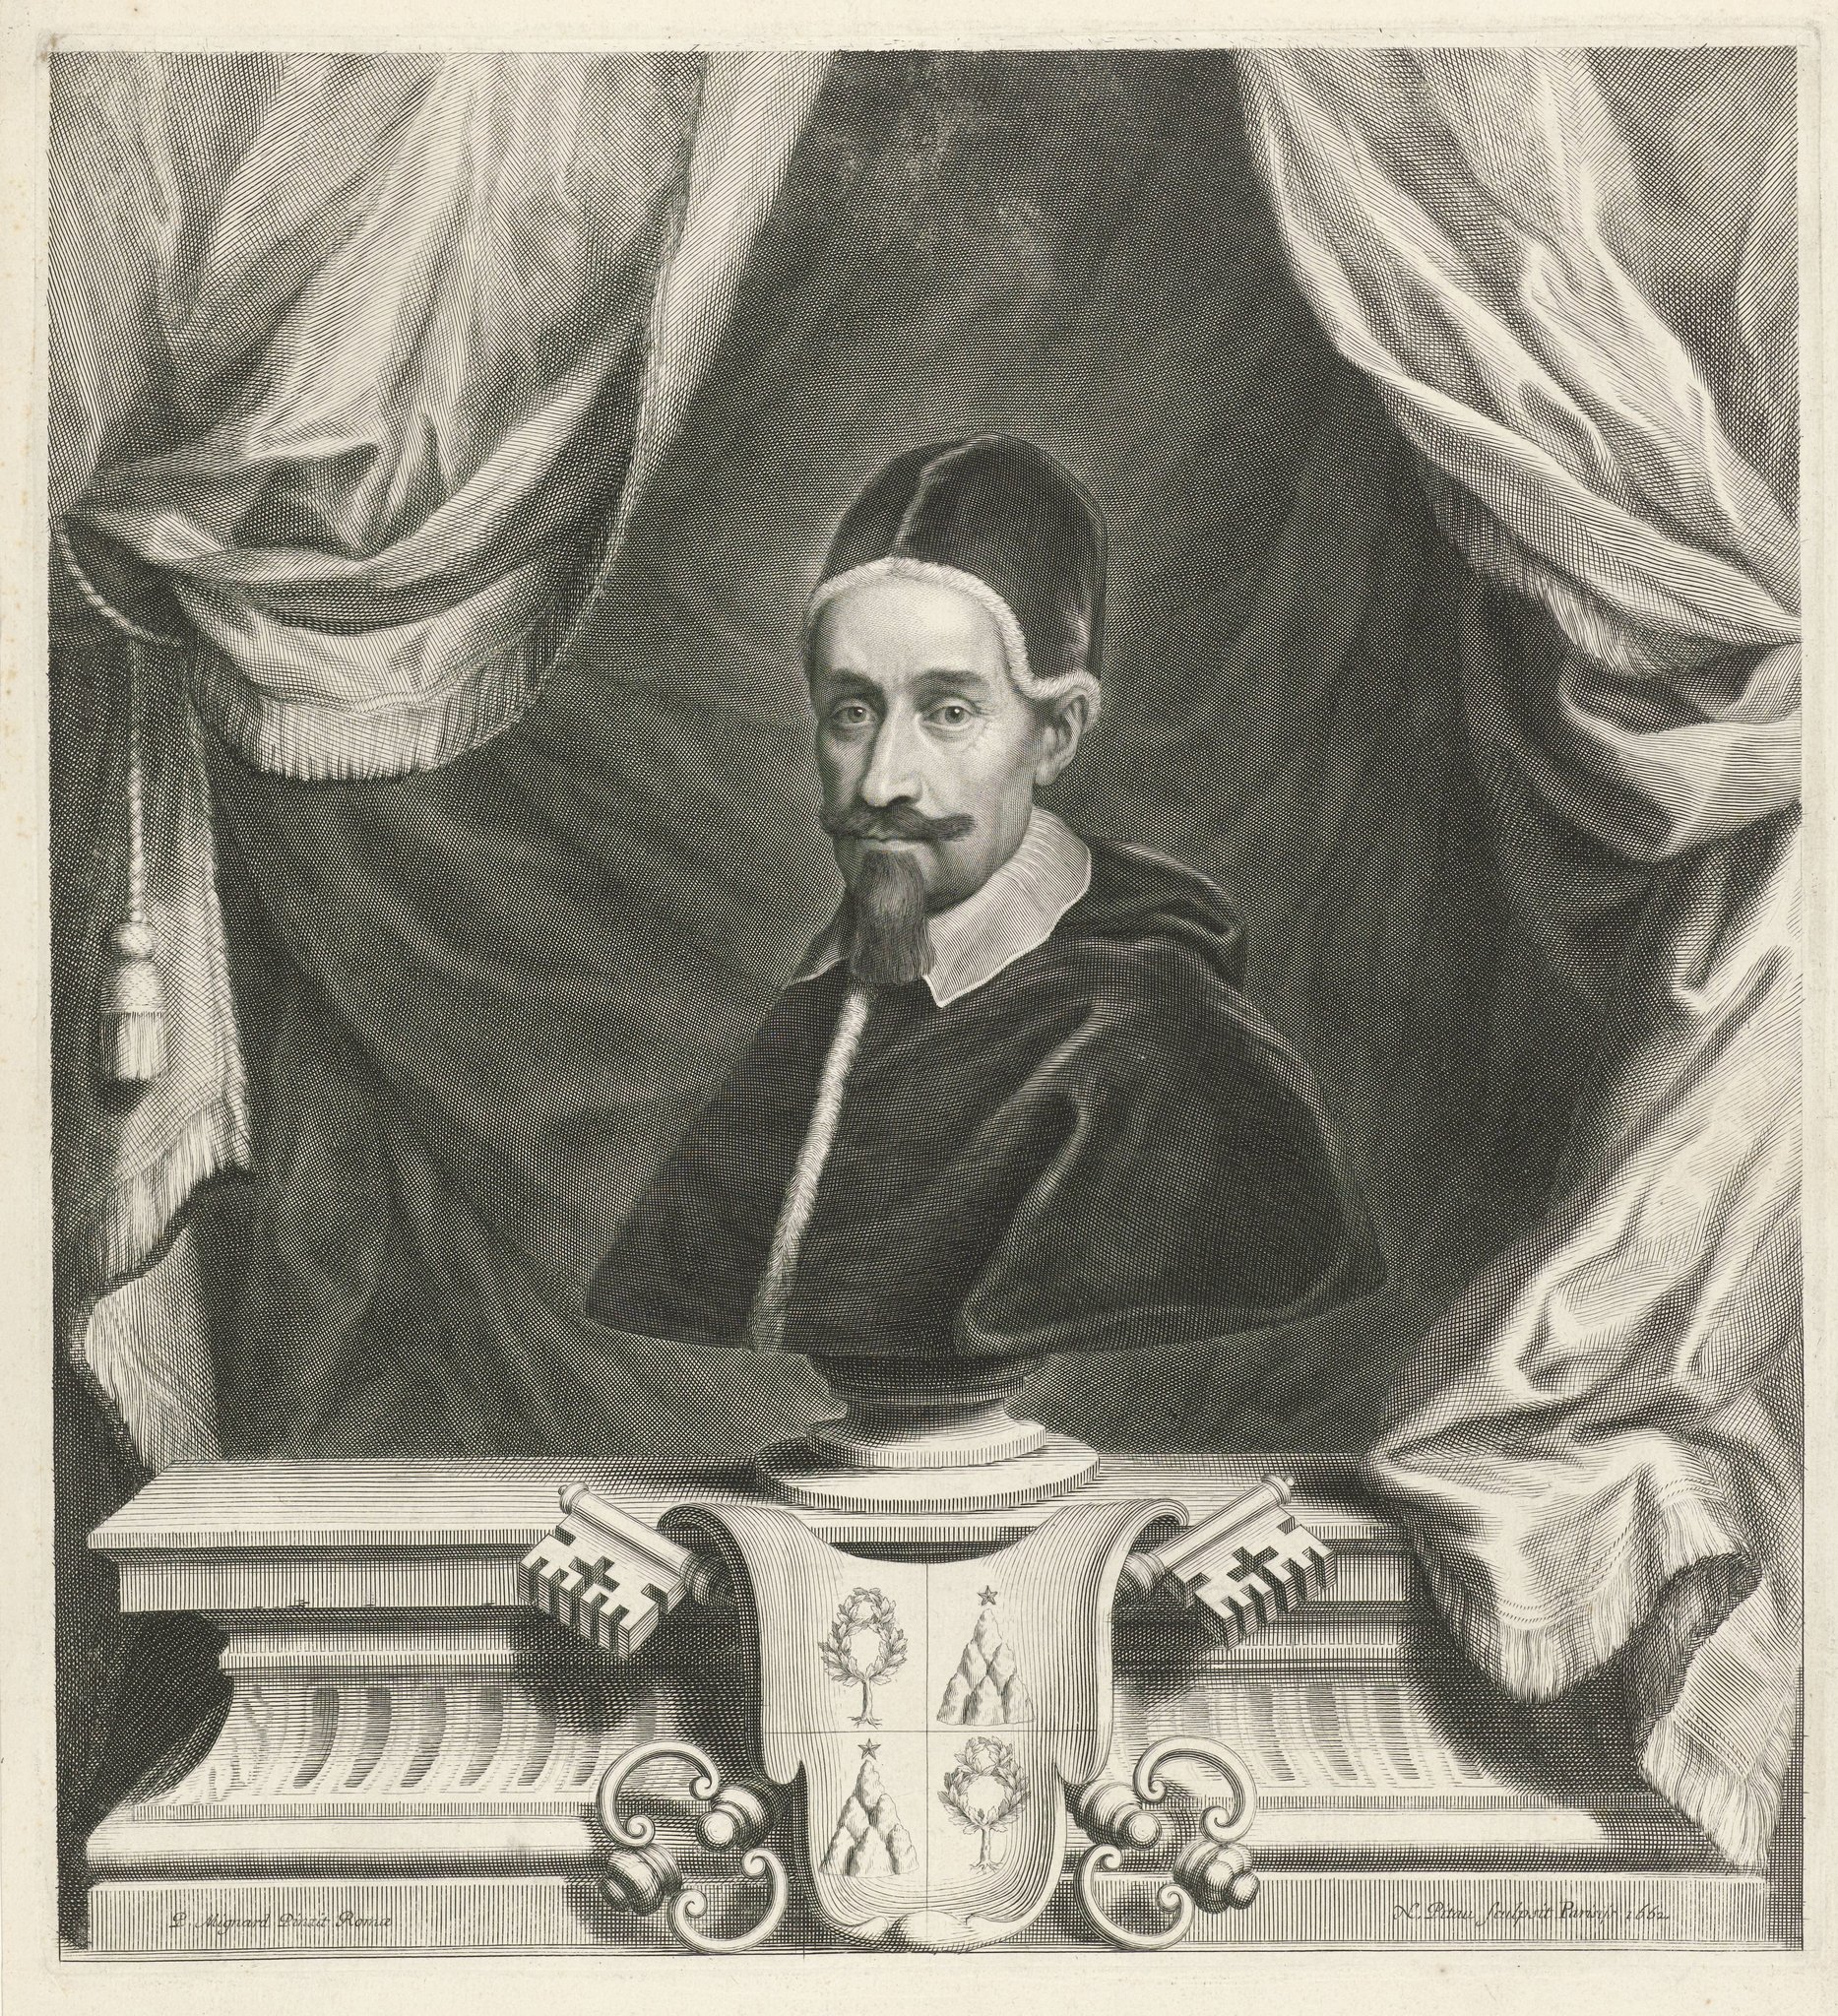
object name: print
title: Busteportret van paus Alexander VII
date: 1662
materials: paper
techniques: engraving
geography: paris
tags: rome, alexander vii, pope, armorial bearing, heraldry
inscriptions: collector's mark: Lugt 240